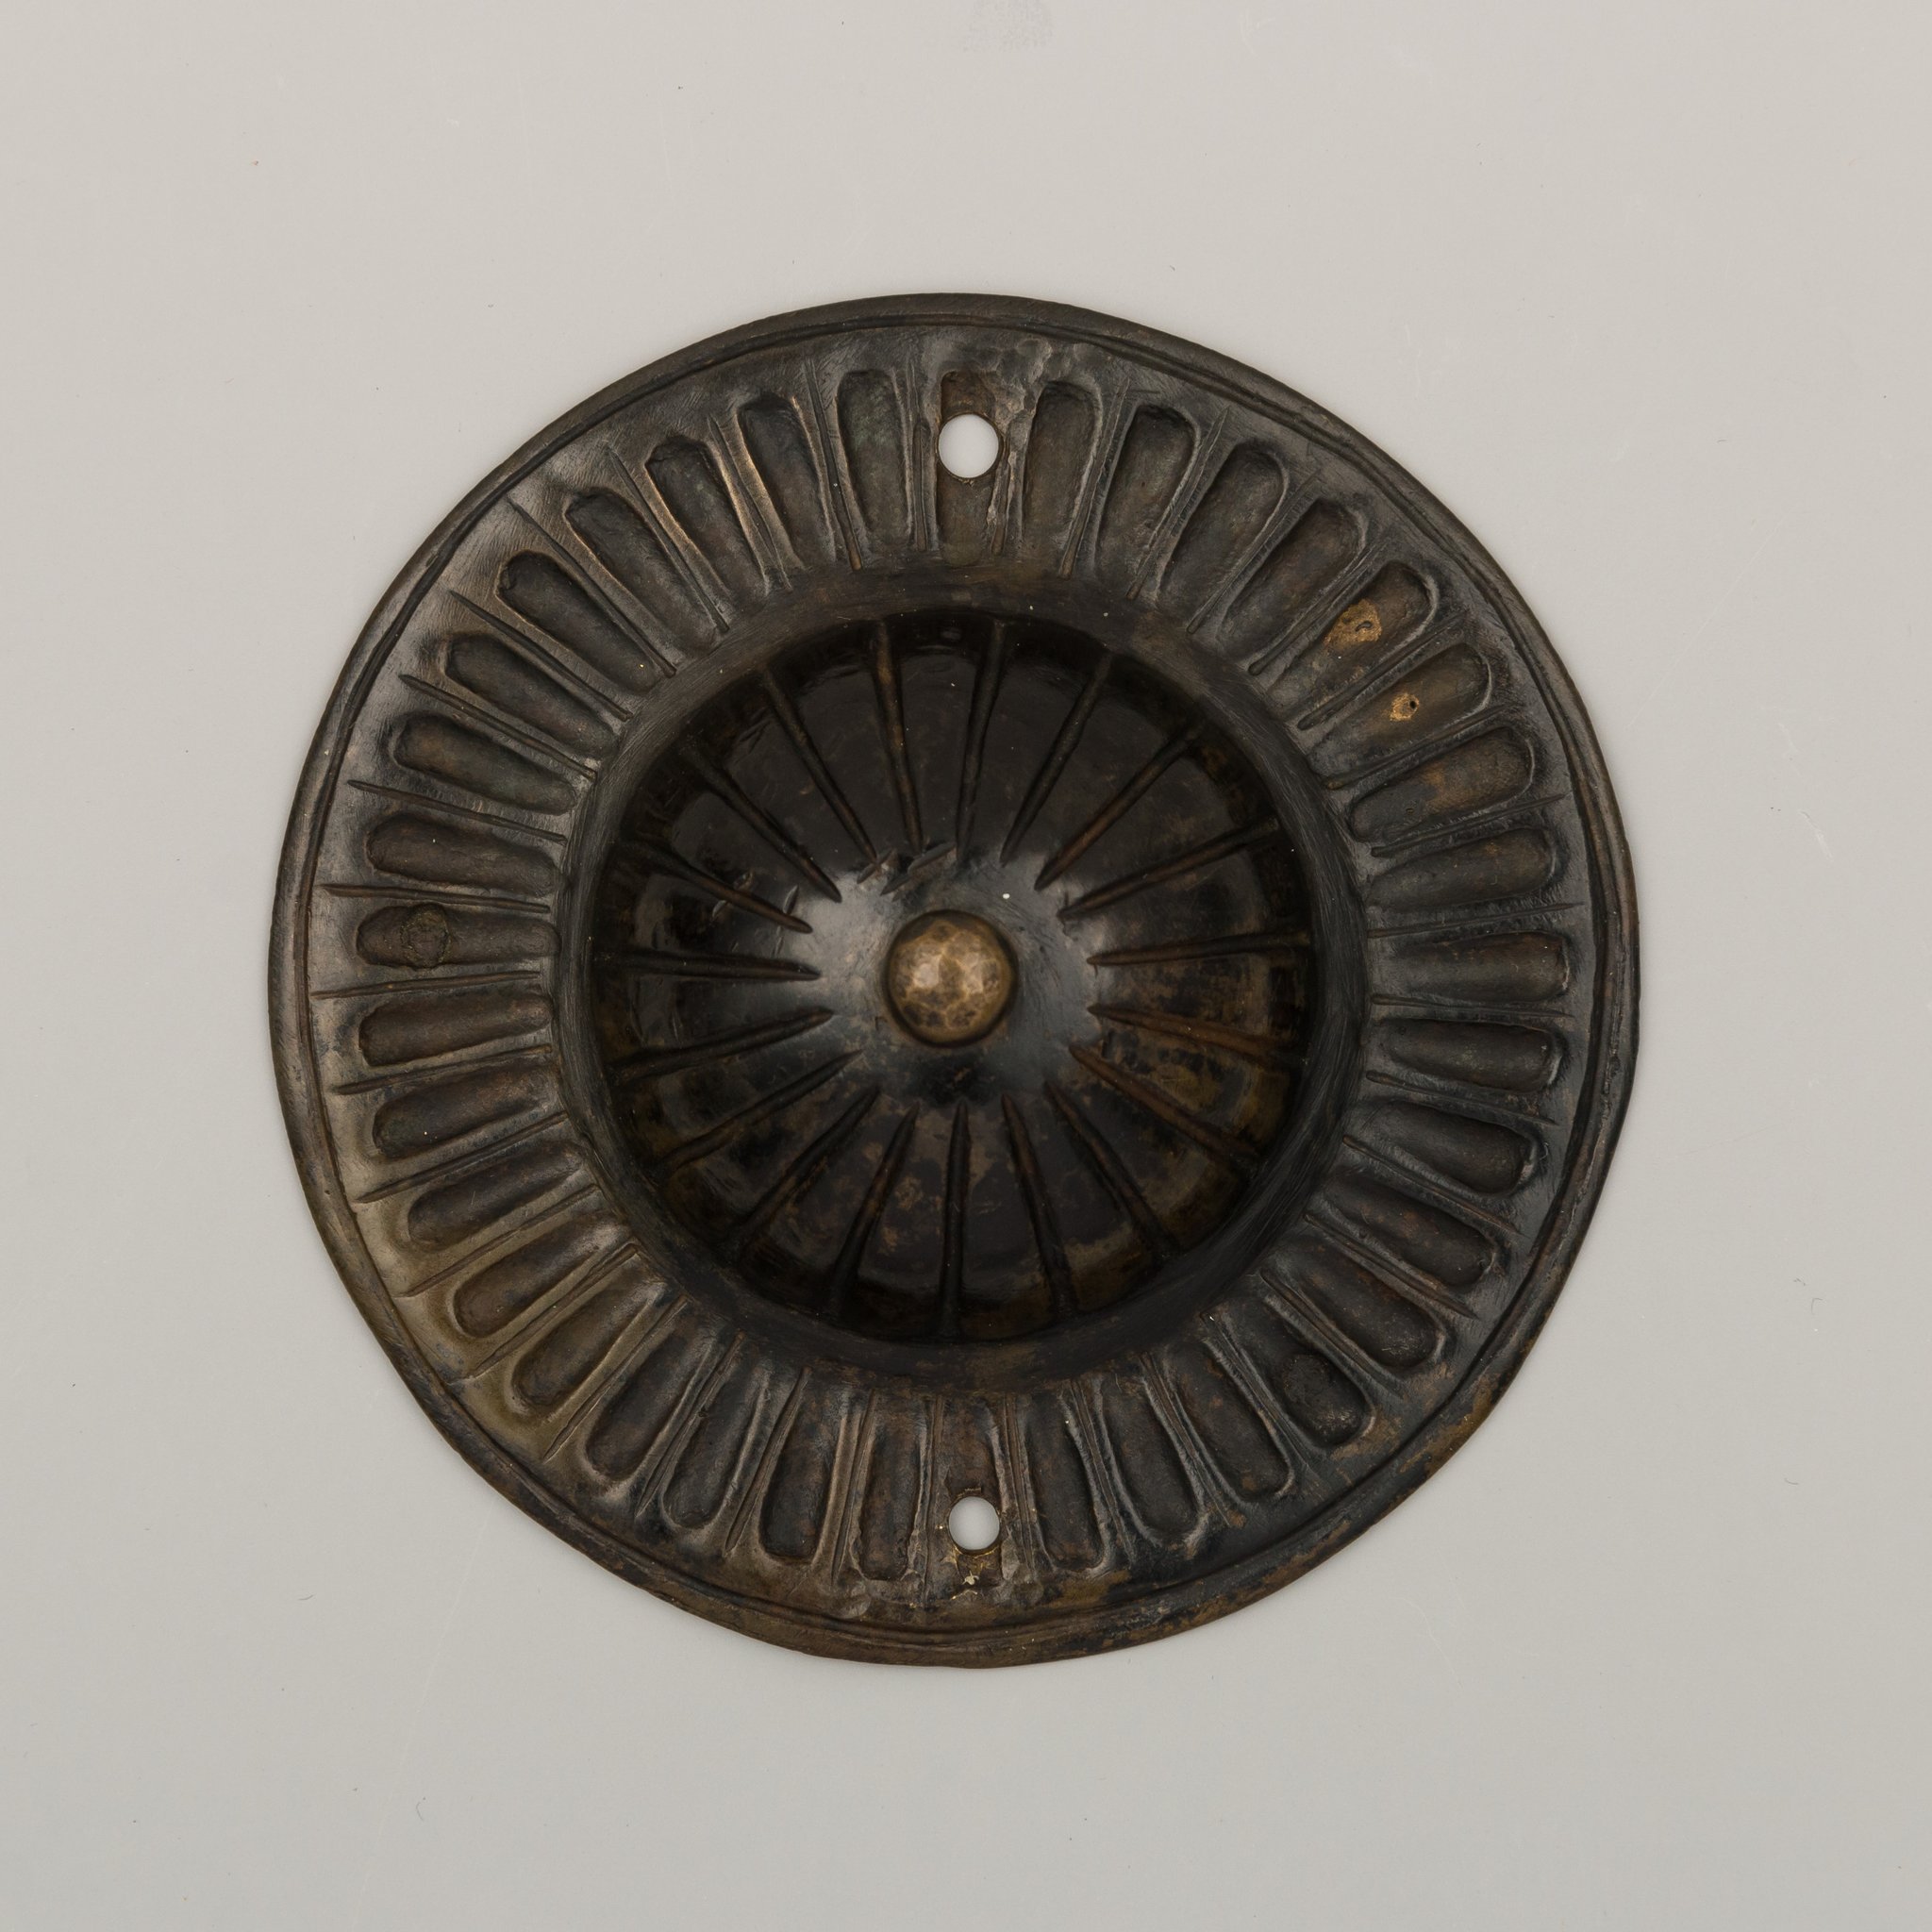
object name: bit bos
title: Bit Boss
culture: french or italian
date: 1501-1633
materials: copper alloy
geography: france